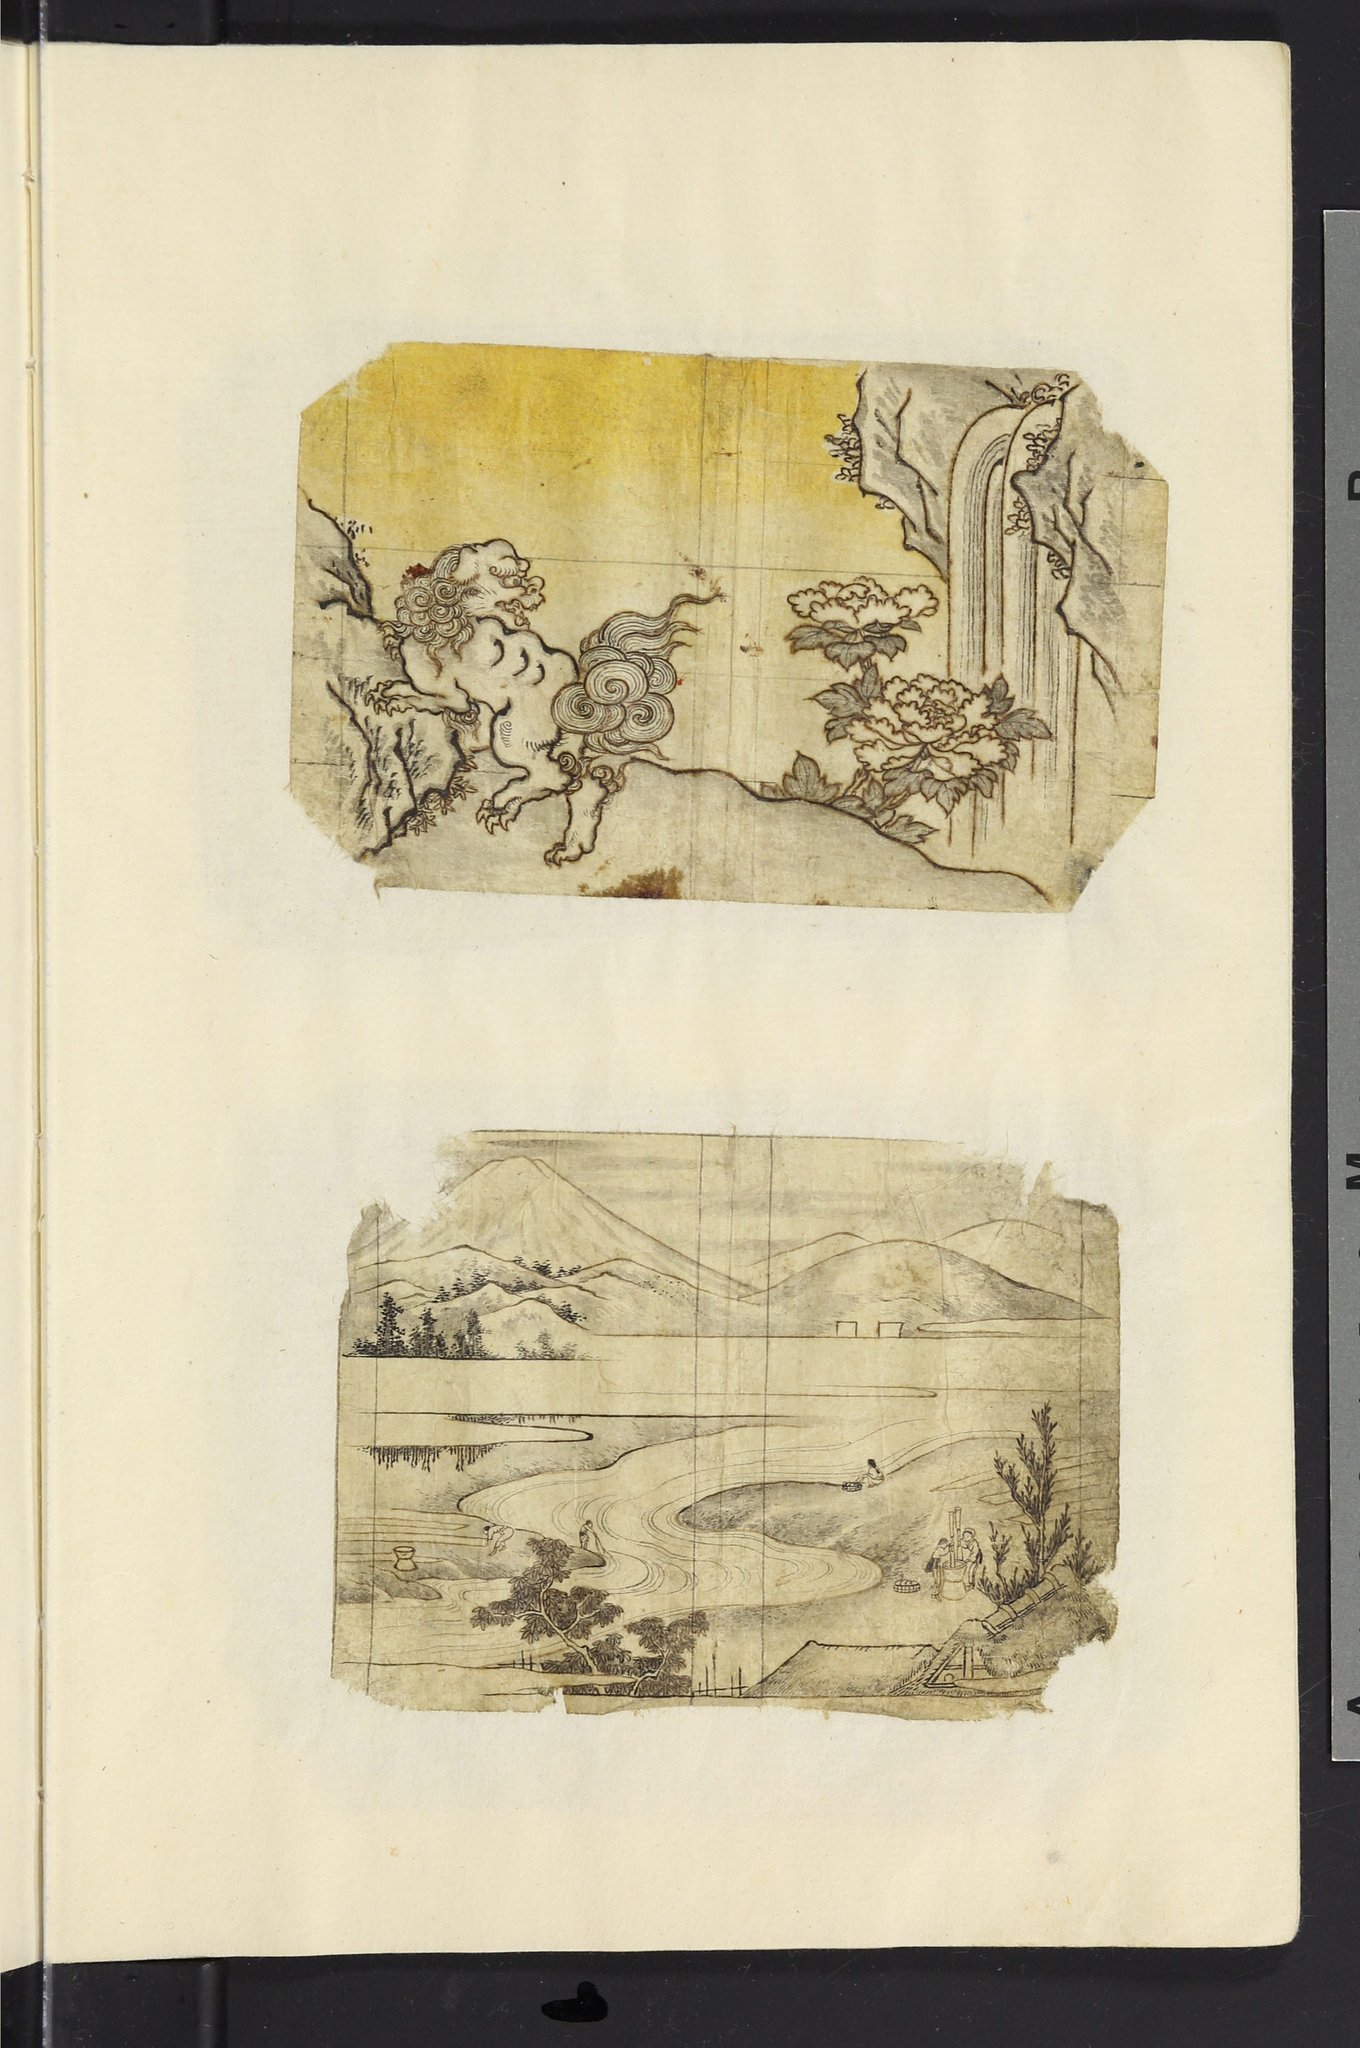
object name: illustrated book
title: Album of Sketches for Lacquer Decoration (Makie) 蒔絵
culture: japanese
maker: unidentified artist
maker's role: artist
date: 1840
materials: ink, paper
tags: animals,waterfalls,flowers,landscapes